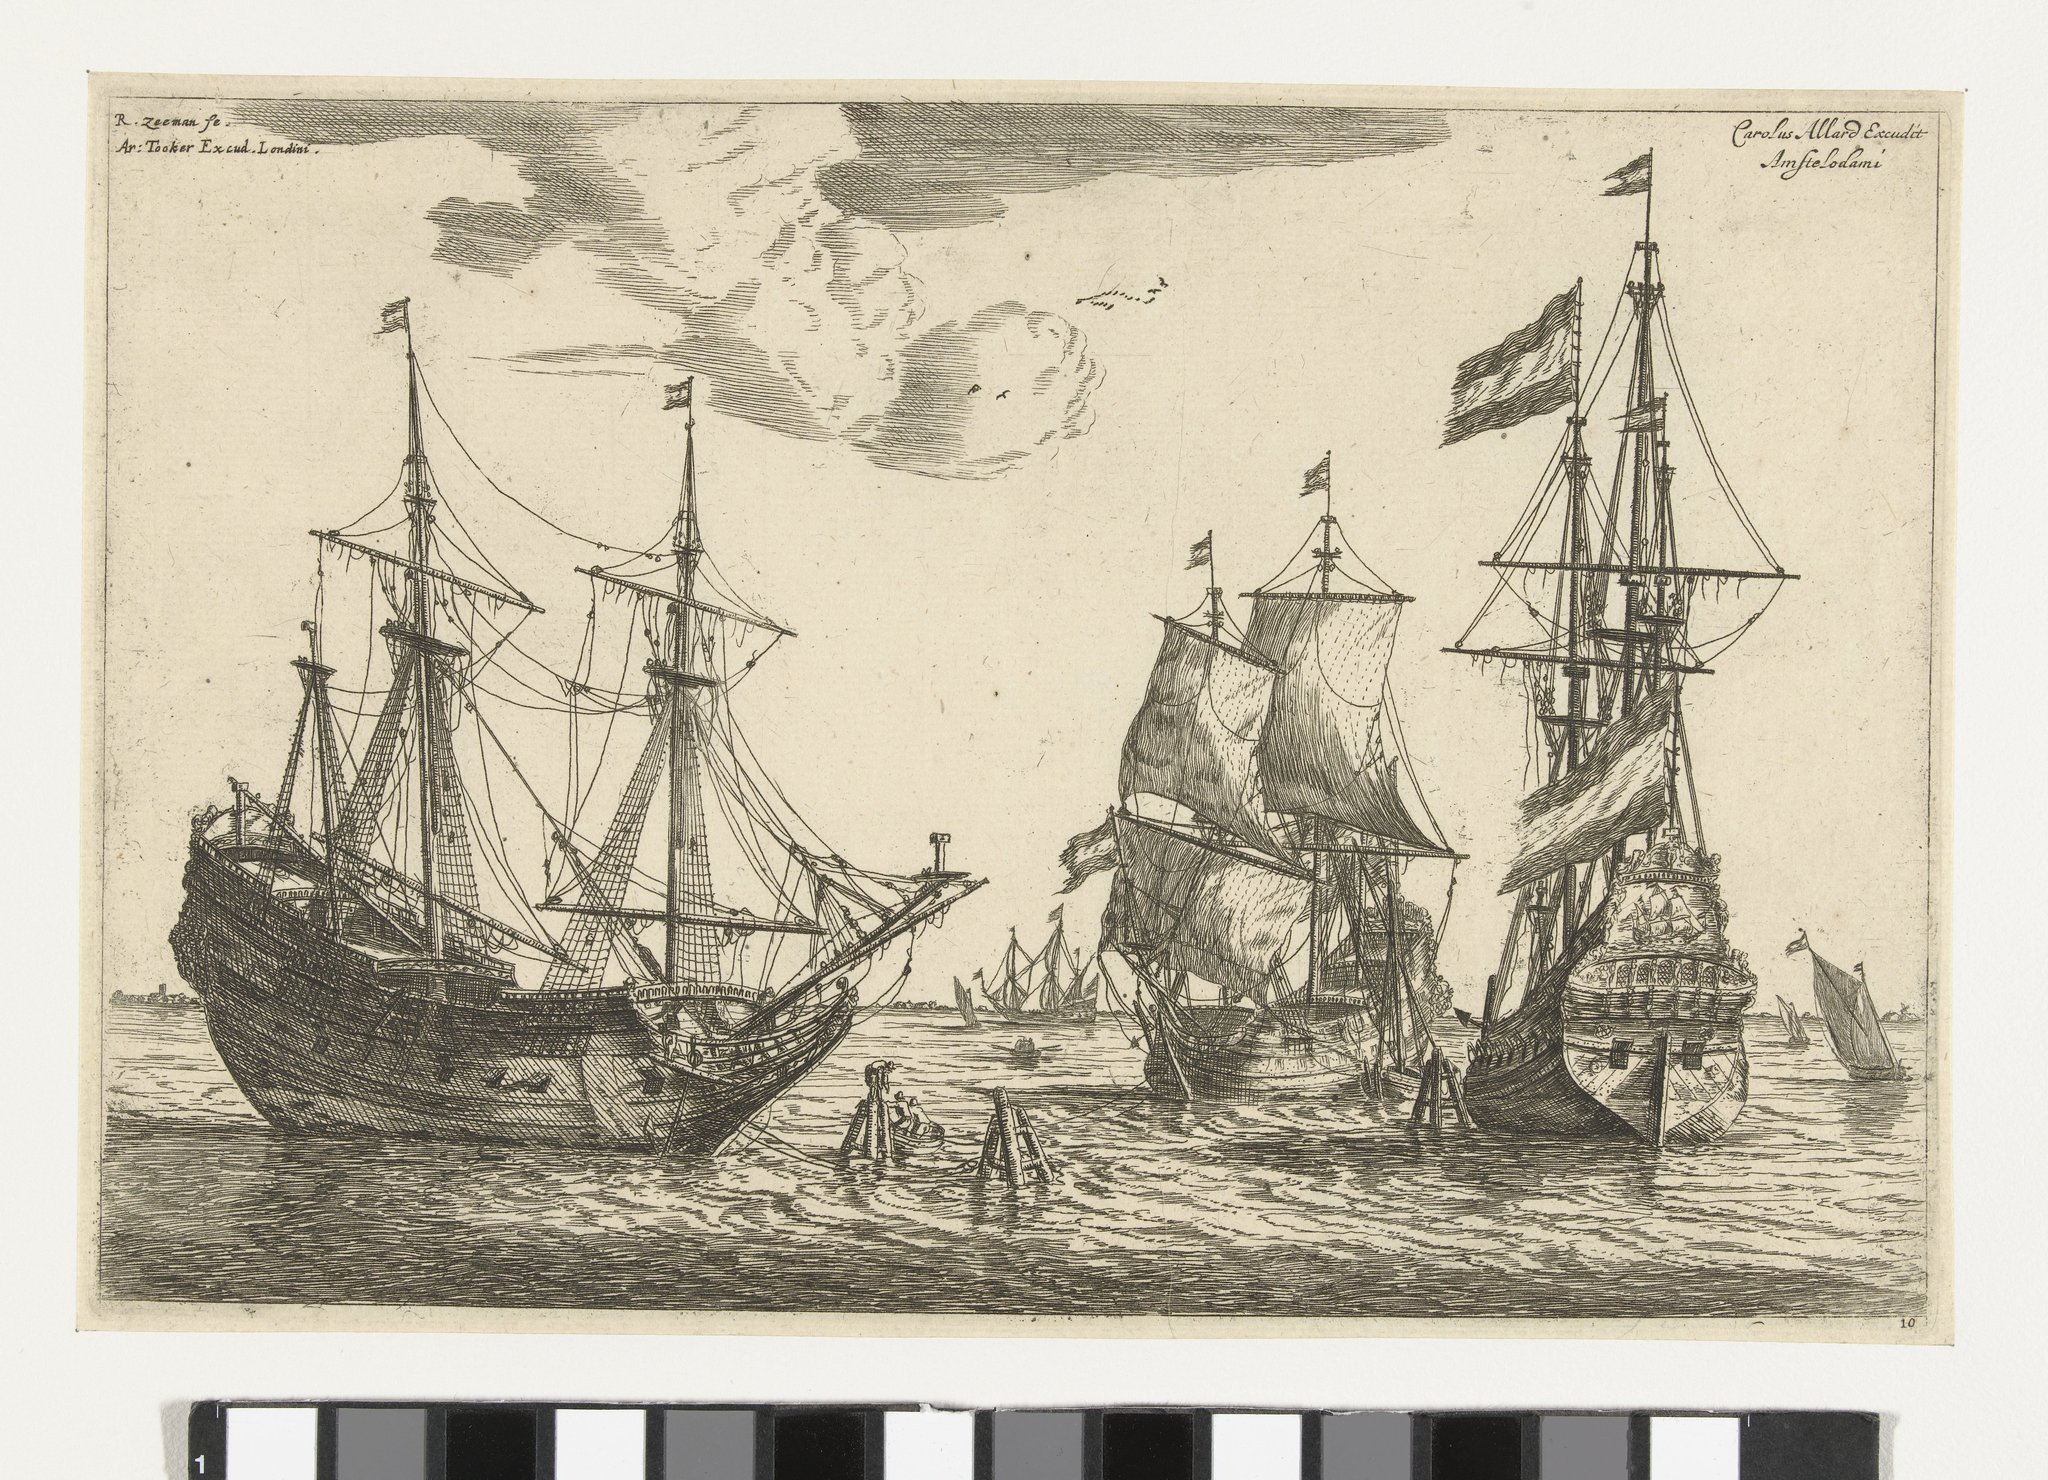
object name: print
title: Drie aangemeerde zeilschepen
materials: paper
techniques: etching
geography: netherlands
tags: sailing-ship, sailing-boat, mooring-buoy, bollard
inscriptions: collector's mark: Lugt 2228a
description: Drie grote zeilschepen, vastgelegd met touwen aan drie meerpalen in het water.